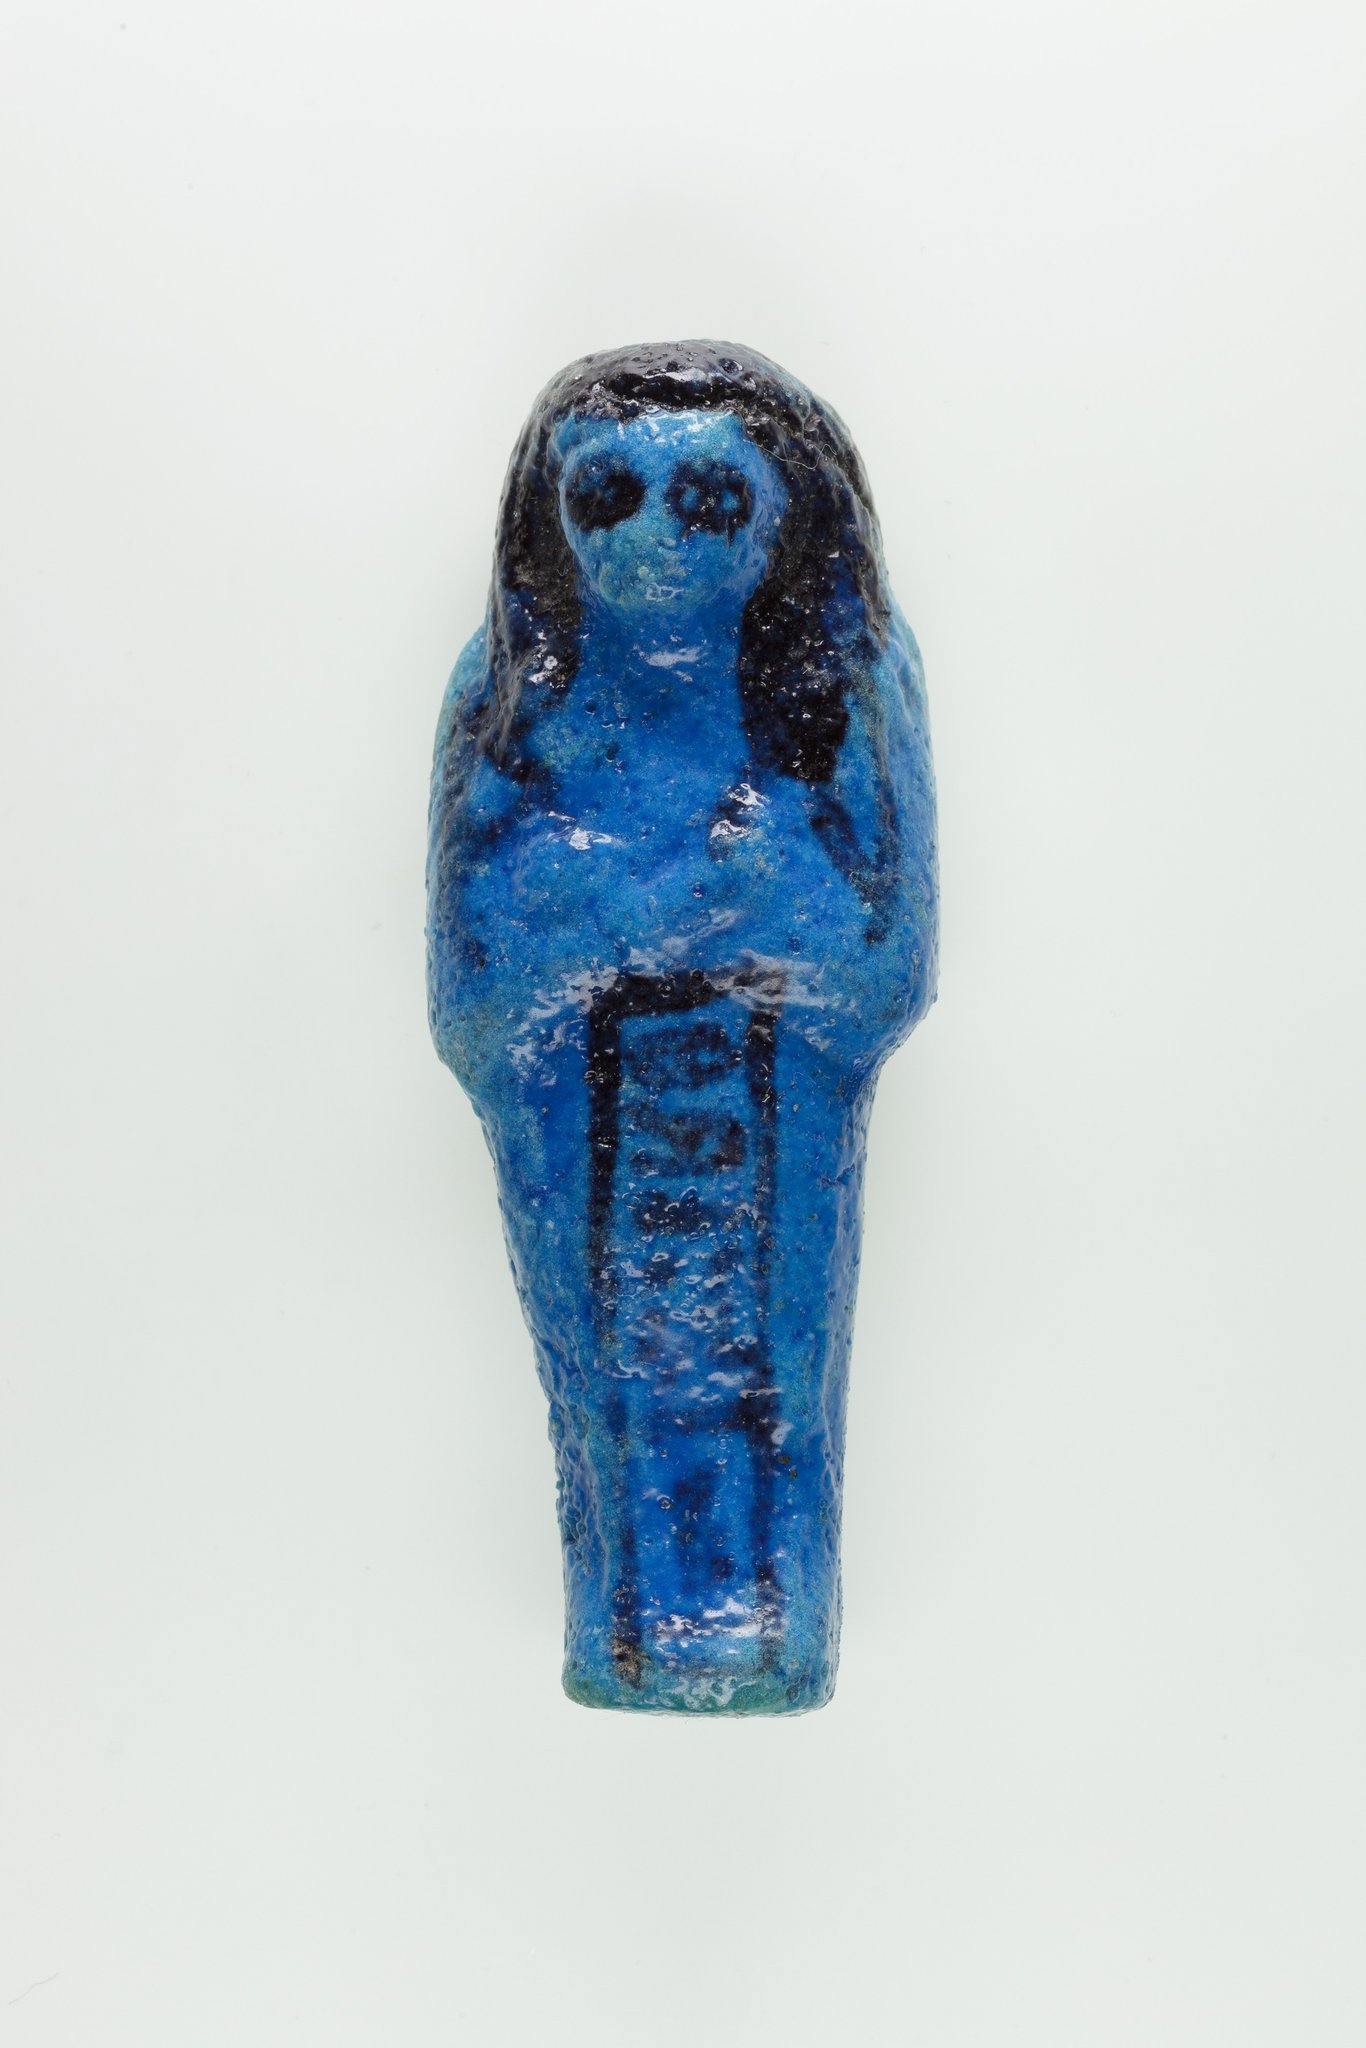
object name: shabti, worker, nauny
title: Worker Shabti of Nauny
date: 1050 BCE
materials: faience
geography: egypt